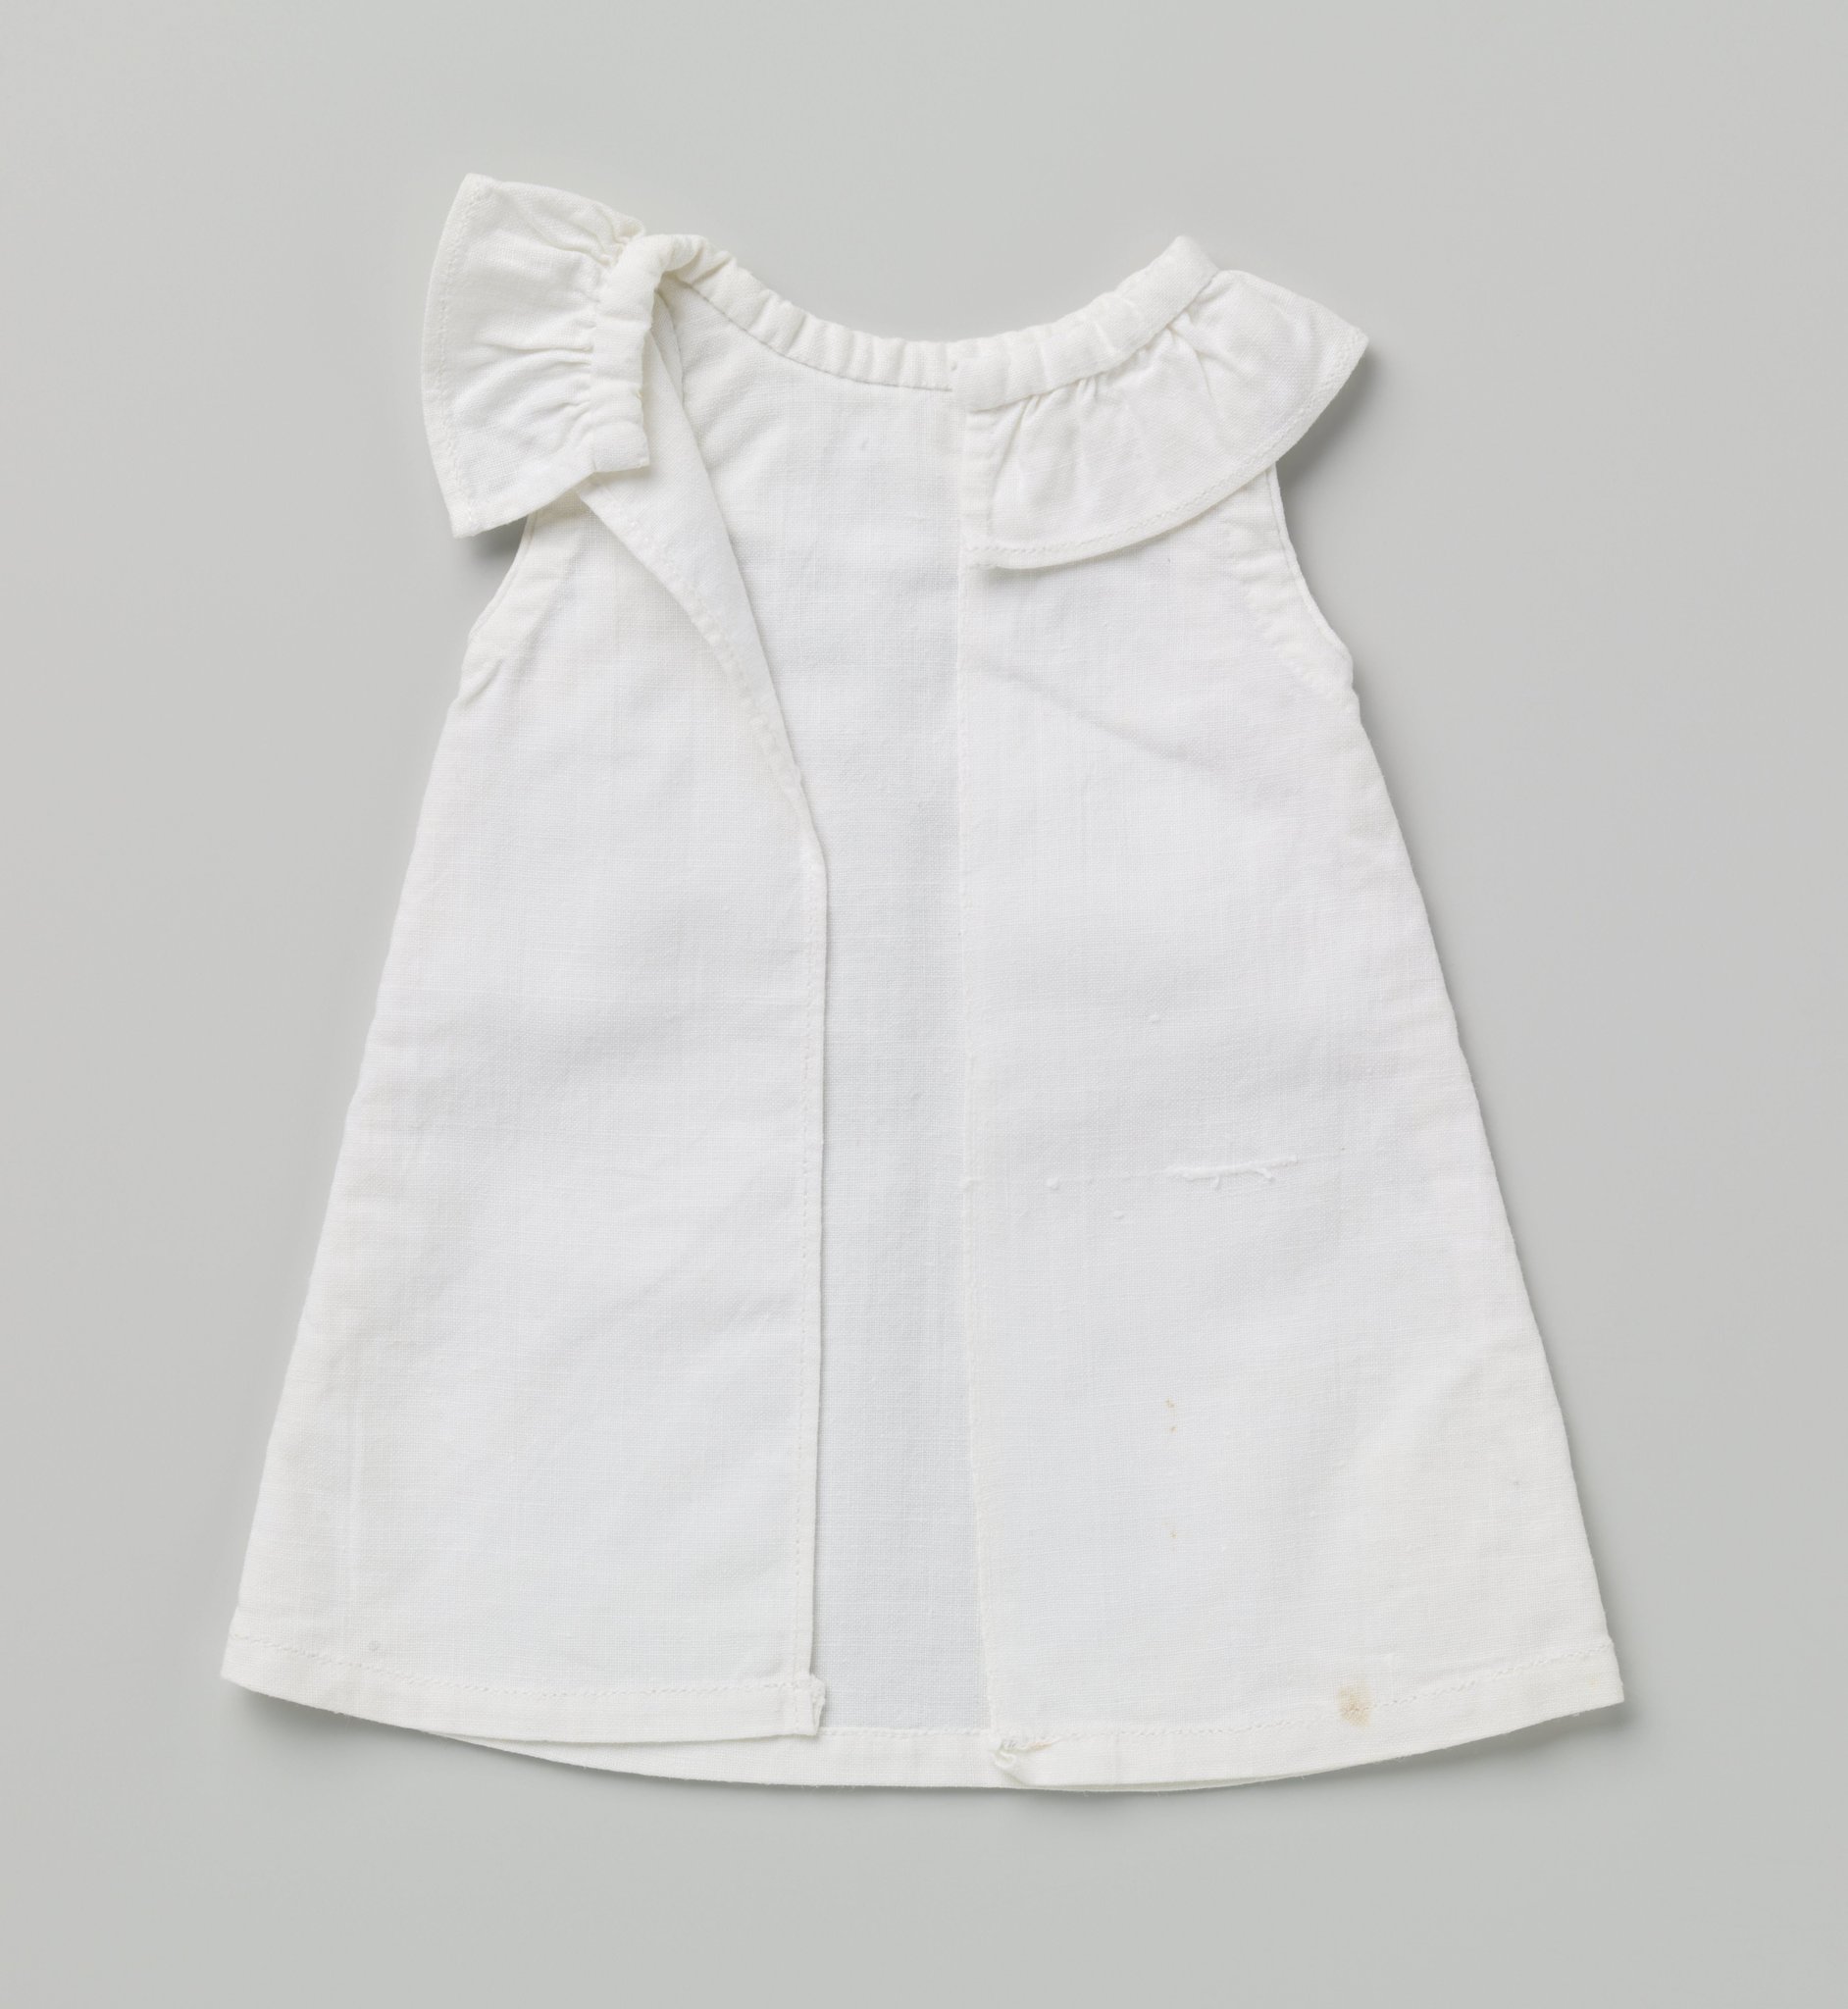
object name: handwerk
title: Babyhemd, mouwloos, van wit linnen met gerimpeld aangezette boord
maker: g. glas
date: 1888-1894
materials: linen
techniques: cockled, sewing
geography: deventer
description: Een linnen manshemd met driekwart mouw. Kleinmodel ondergoed. Handwerk vervaardigd op de Normaalschool te Deventer voor de akte `Nuttige handwerken'.